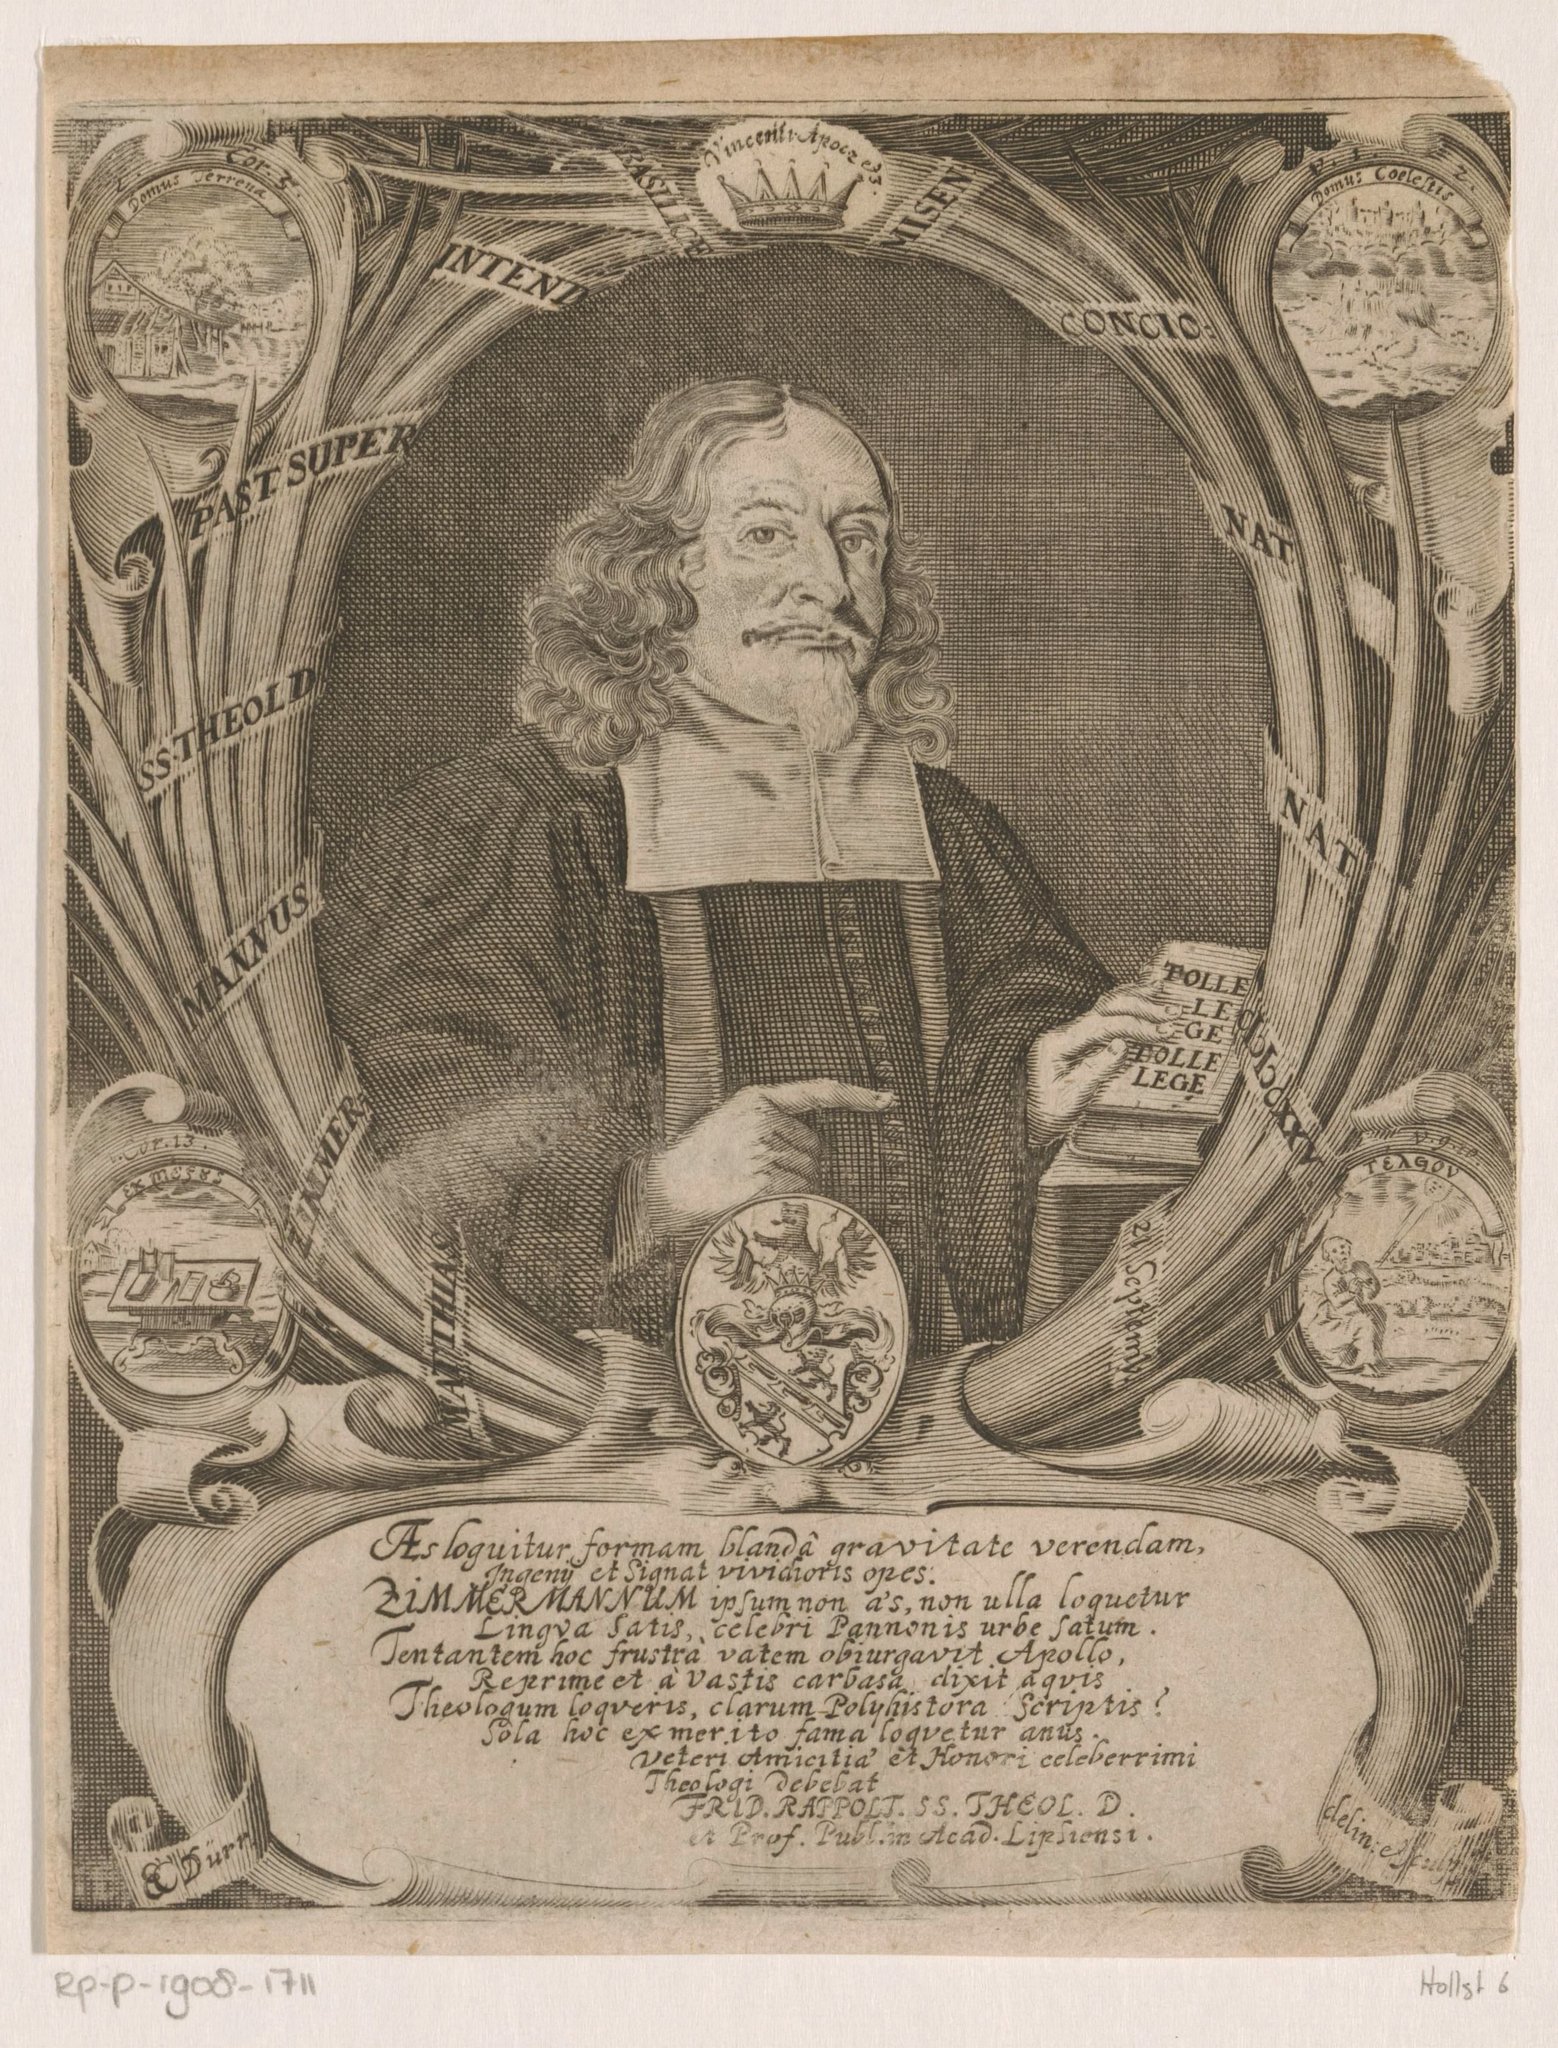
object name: print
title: Portret van Matthias Zimmermann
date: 1670-1680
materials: paper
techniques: engraving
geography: saxony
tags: the new jerusalem, science and technology, historical persons, theology; 'theologia' (ripa), book, farm or solitary house in landscape, index finger forwards, pointing, indicating, armorial bearing, heraldry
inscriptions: collector's mark: Lugt 2228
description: Portret omlijst met vier medaillons met illustraties van Bijbelverzen. Onder het portret een wapenschild en cartouche met lofdicht.